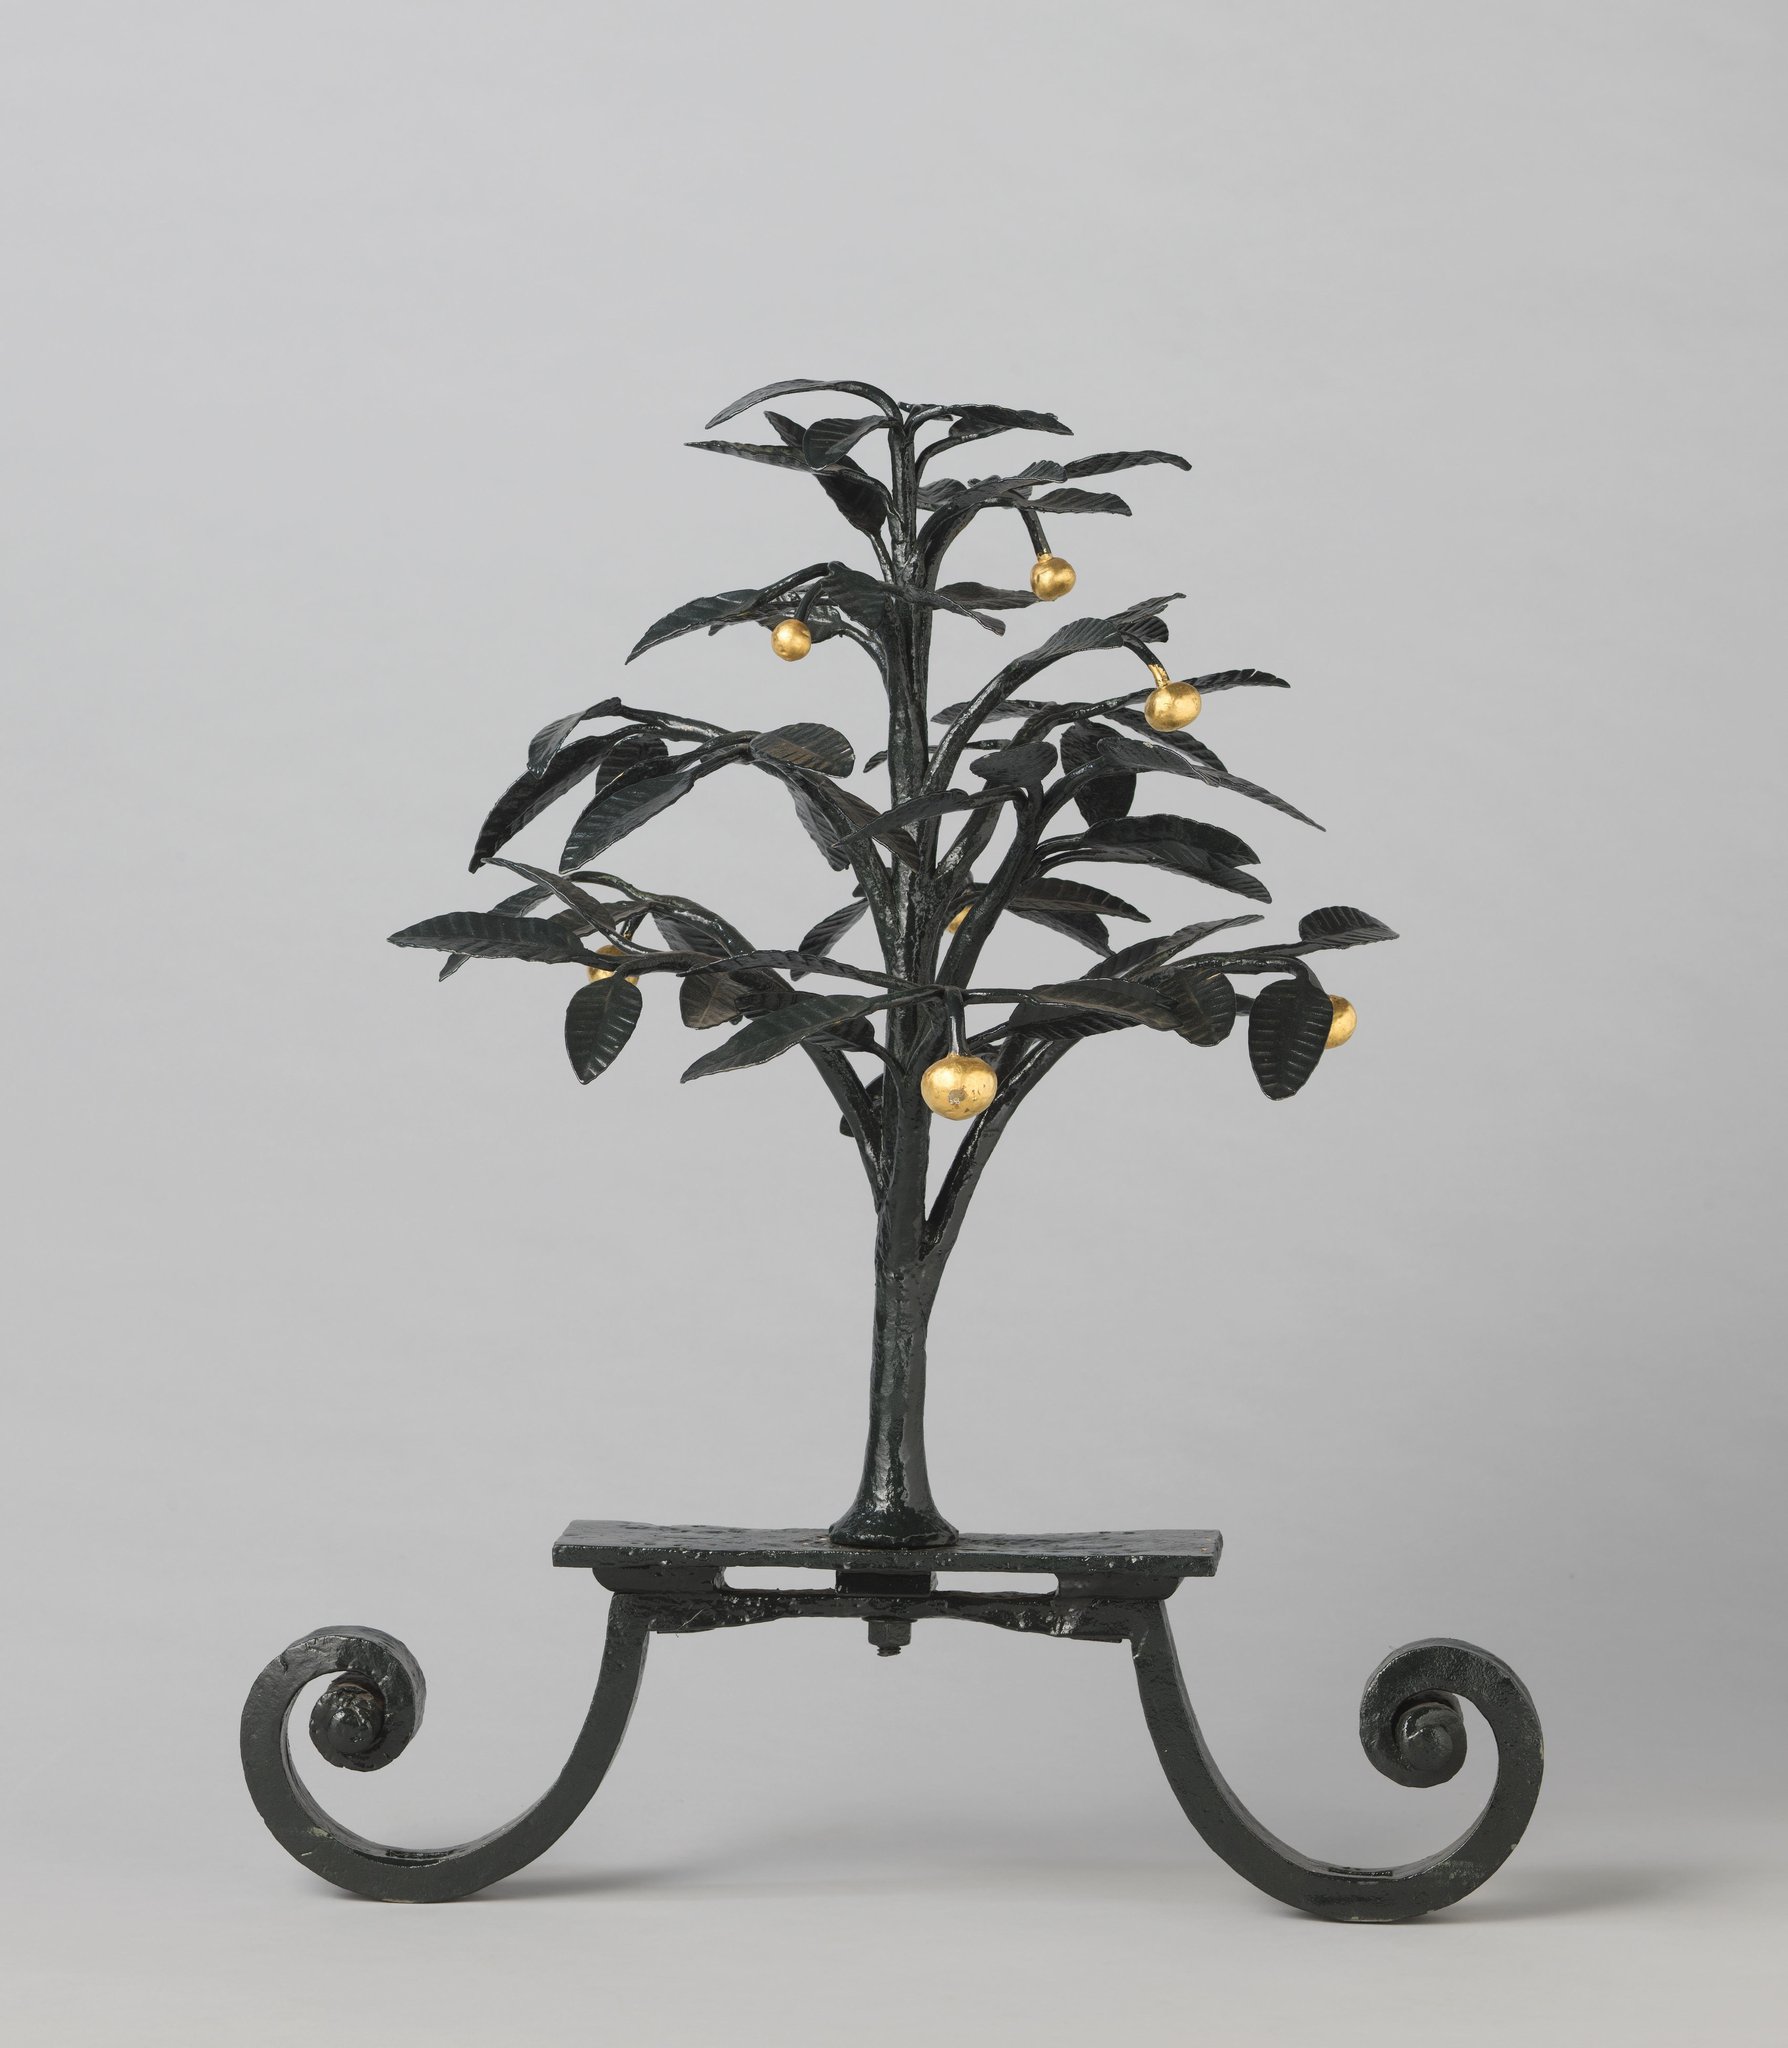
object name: hek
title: Oranjeboom van het inrijhek Huize de Voorst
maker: daniël marot (i)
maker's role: draughtsman, print maker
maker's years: 1661-1752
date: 1675-1700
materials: iron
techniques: forging, gilding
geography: warnsveld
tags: huis de voorst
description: Smeedijzeren oranjeboom van het inrijhek van Huize de Voorst, deels verguld.